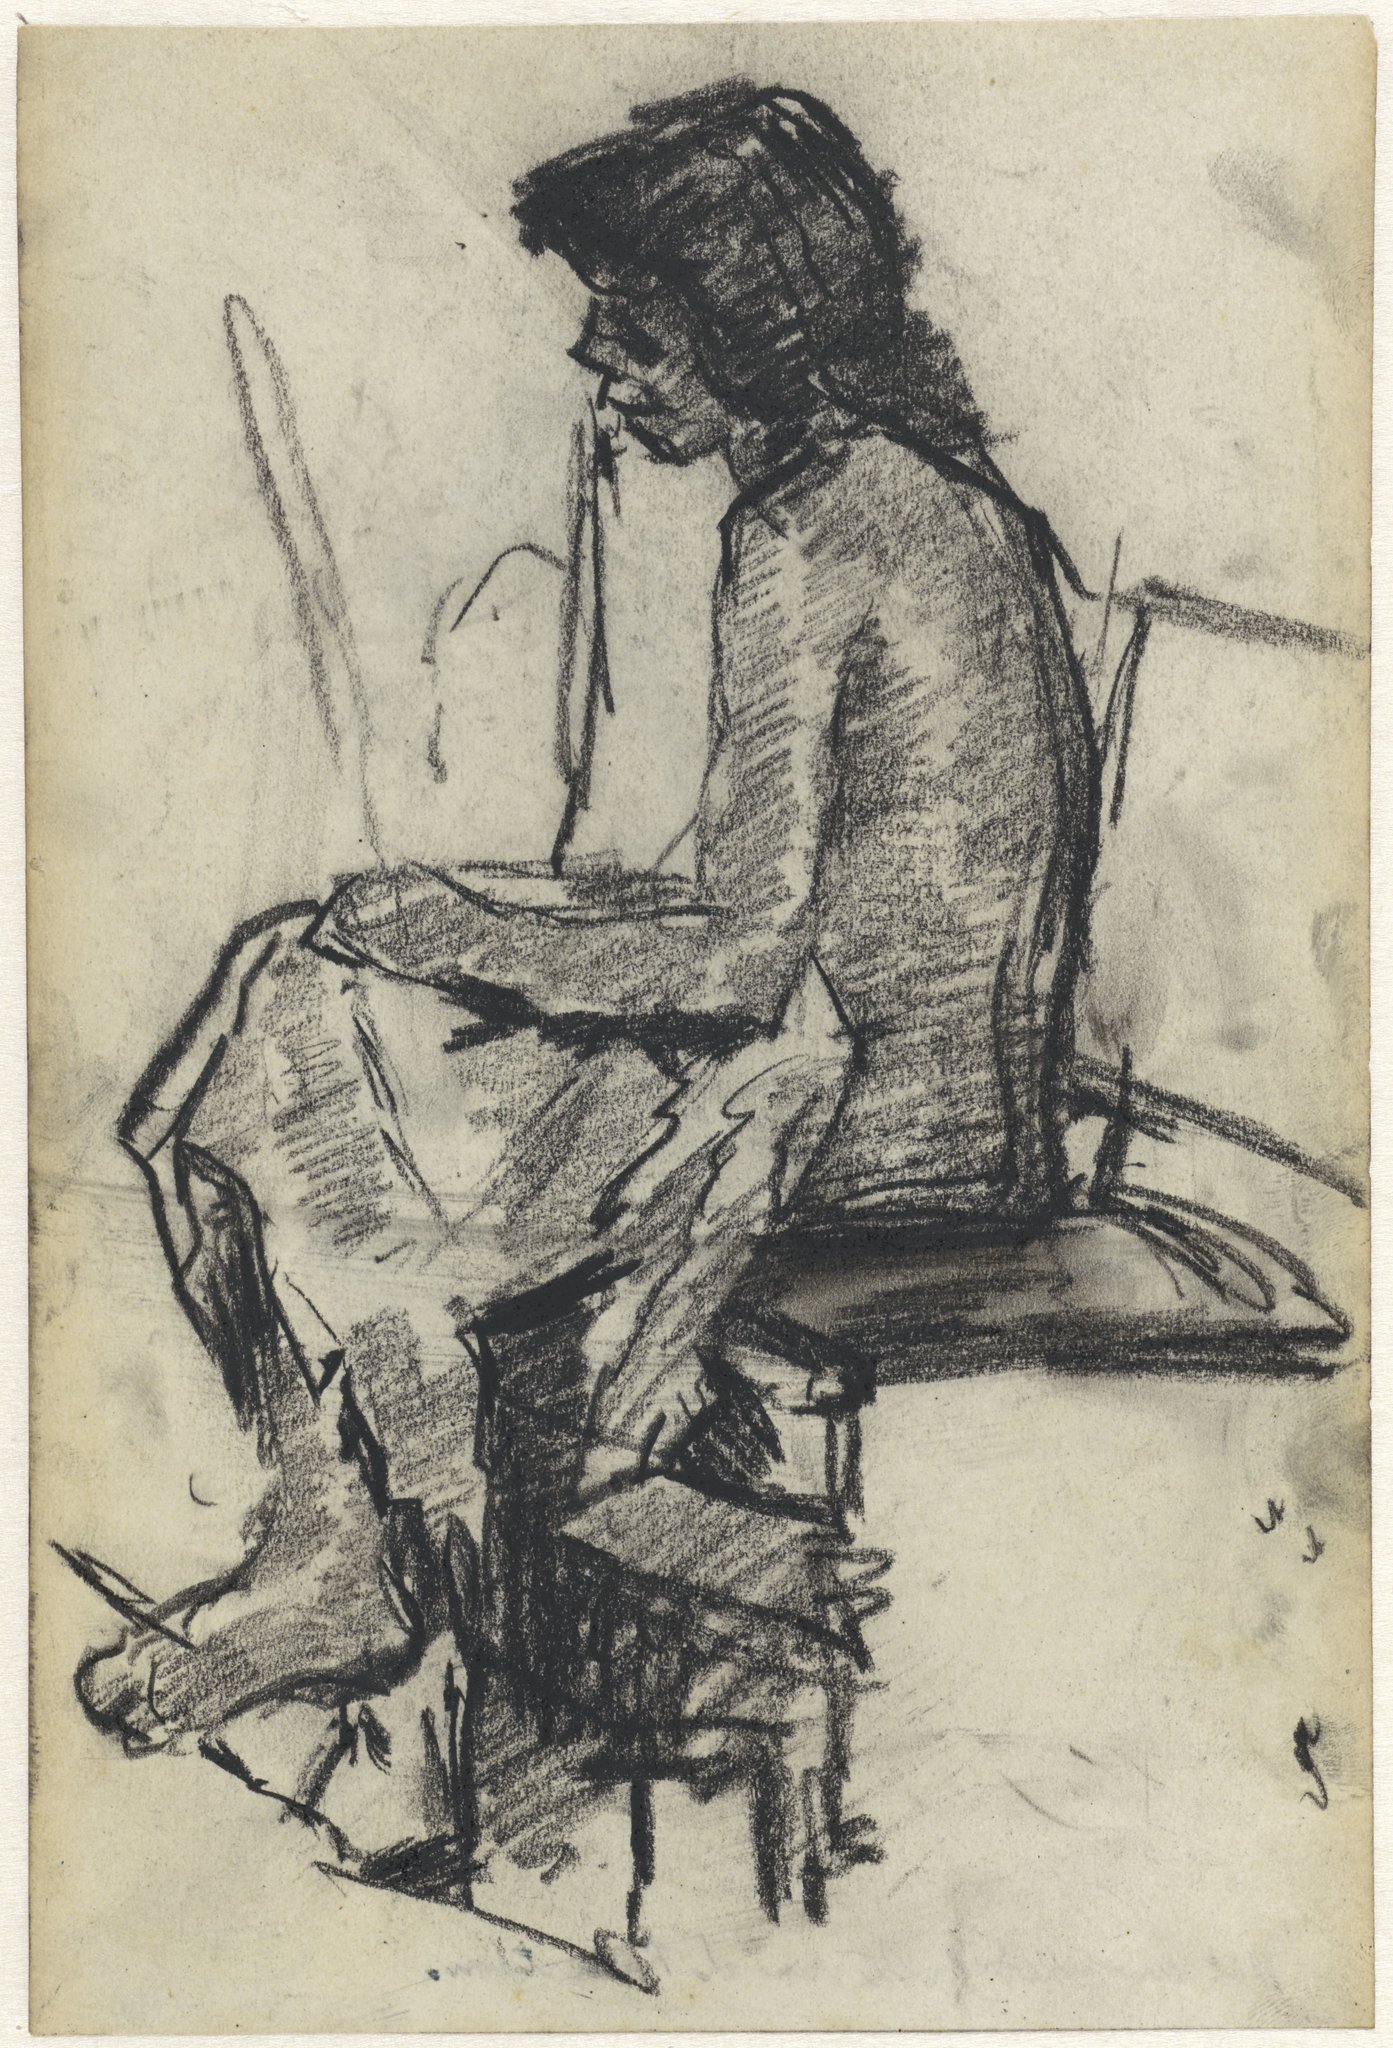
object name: drawing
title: Schets van een naakt meisje, zittend met een doek over de knieën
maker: suze robertson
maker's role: draughtsman, painter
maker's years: 1855-1922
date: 1865-1922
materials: chalk, paper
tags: sitting figure